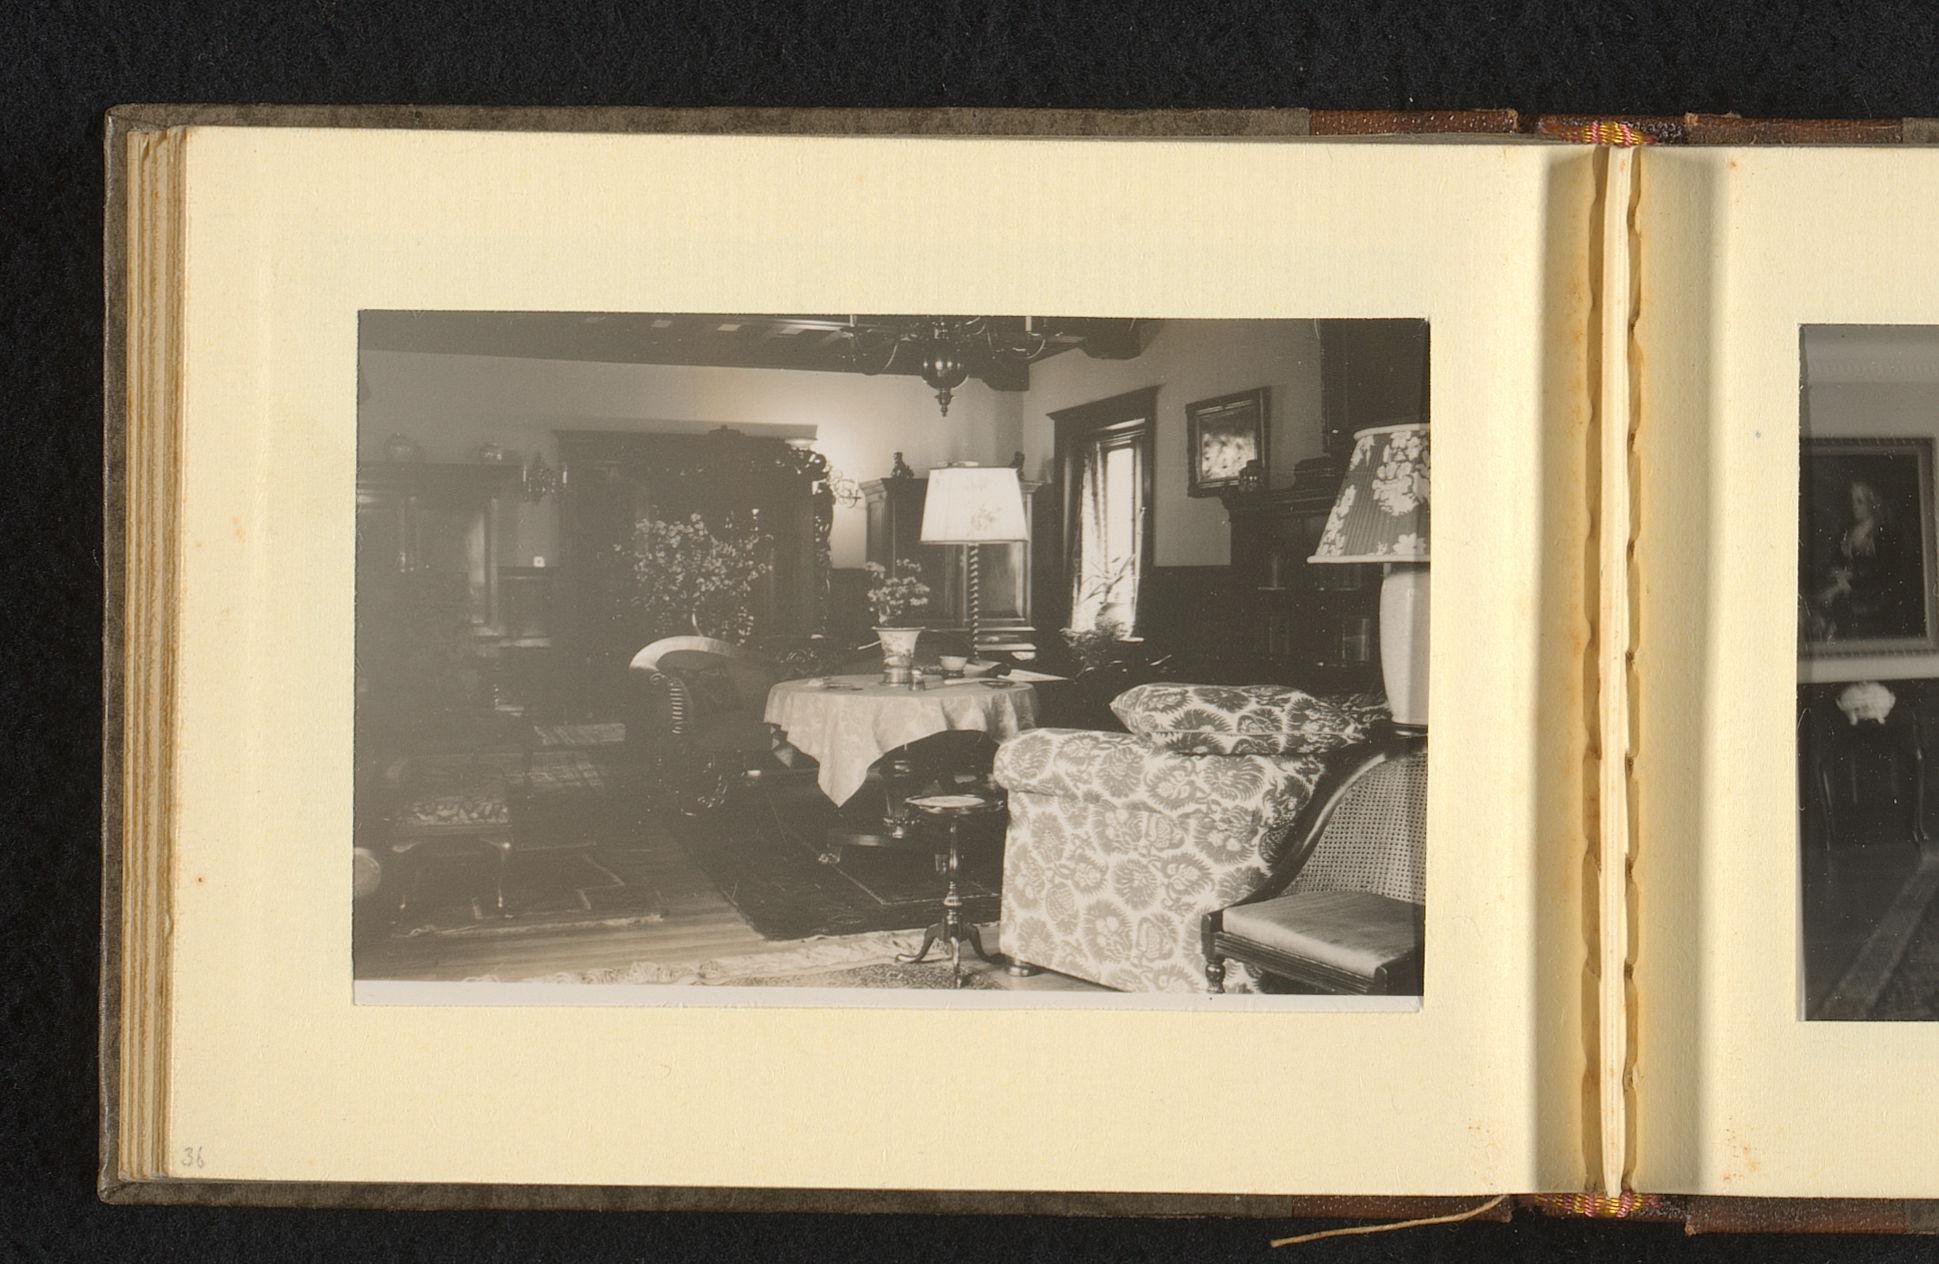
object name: photograph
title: Interieur van een zitkamer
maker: norbert van den berg (1901-1972)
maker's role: amateurfotograaf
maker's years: 1901-1972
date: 1935-1950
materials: paper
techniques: gelatin silver print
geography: netherlands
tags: interior of the house, living-room, parlour, sitting-room